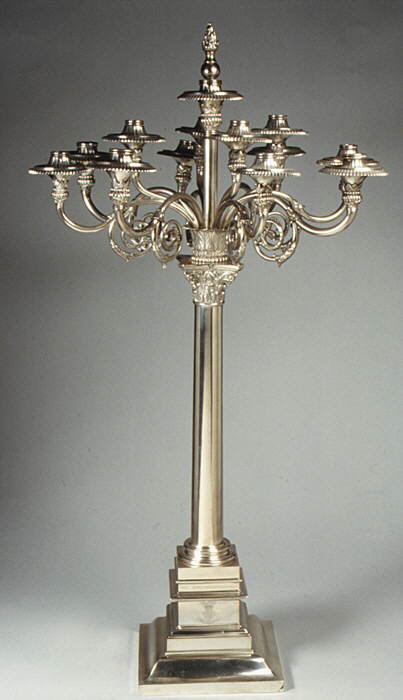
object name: candelabrum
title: Twelve-light candelabrum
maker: matthew boulton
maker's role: maker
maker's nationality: british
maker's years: 1728-1809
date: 1805-1806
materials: silver